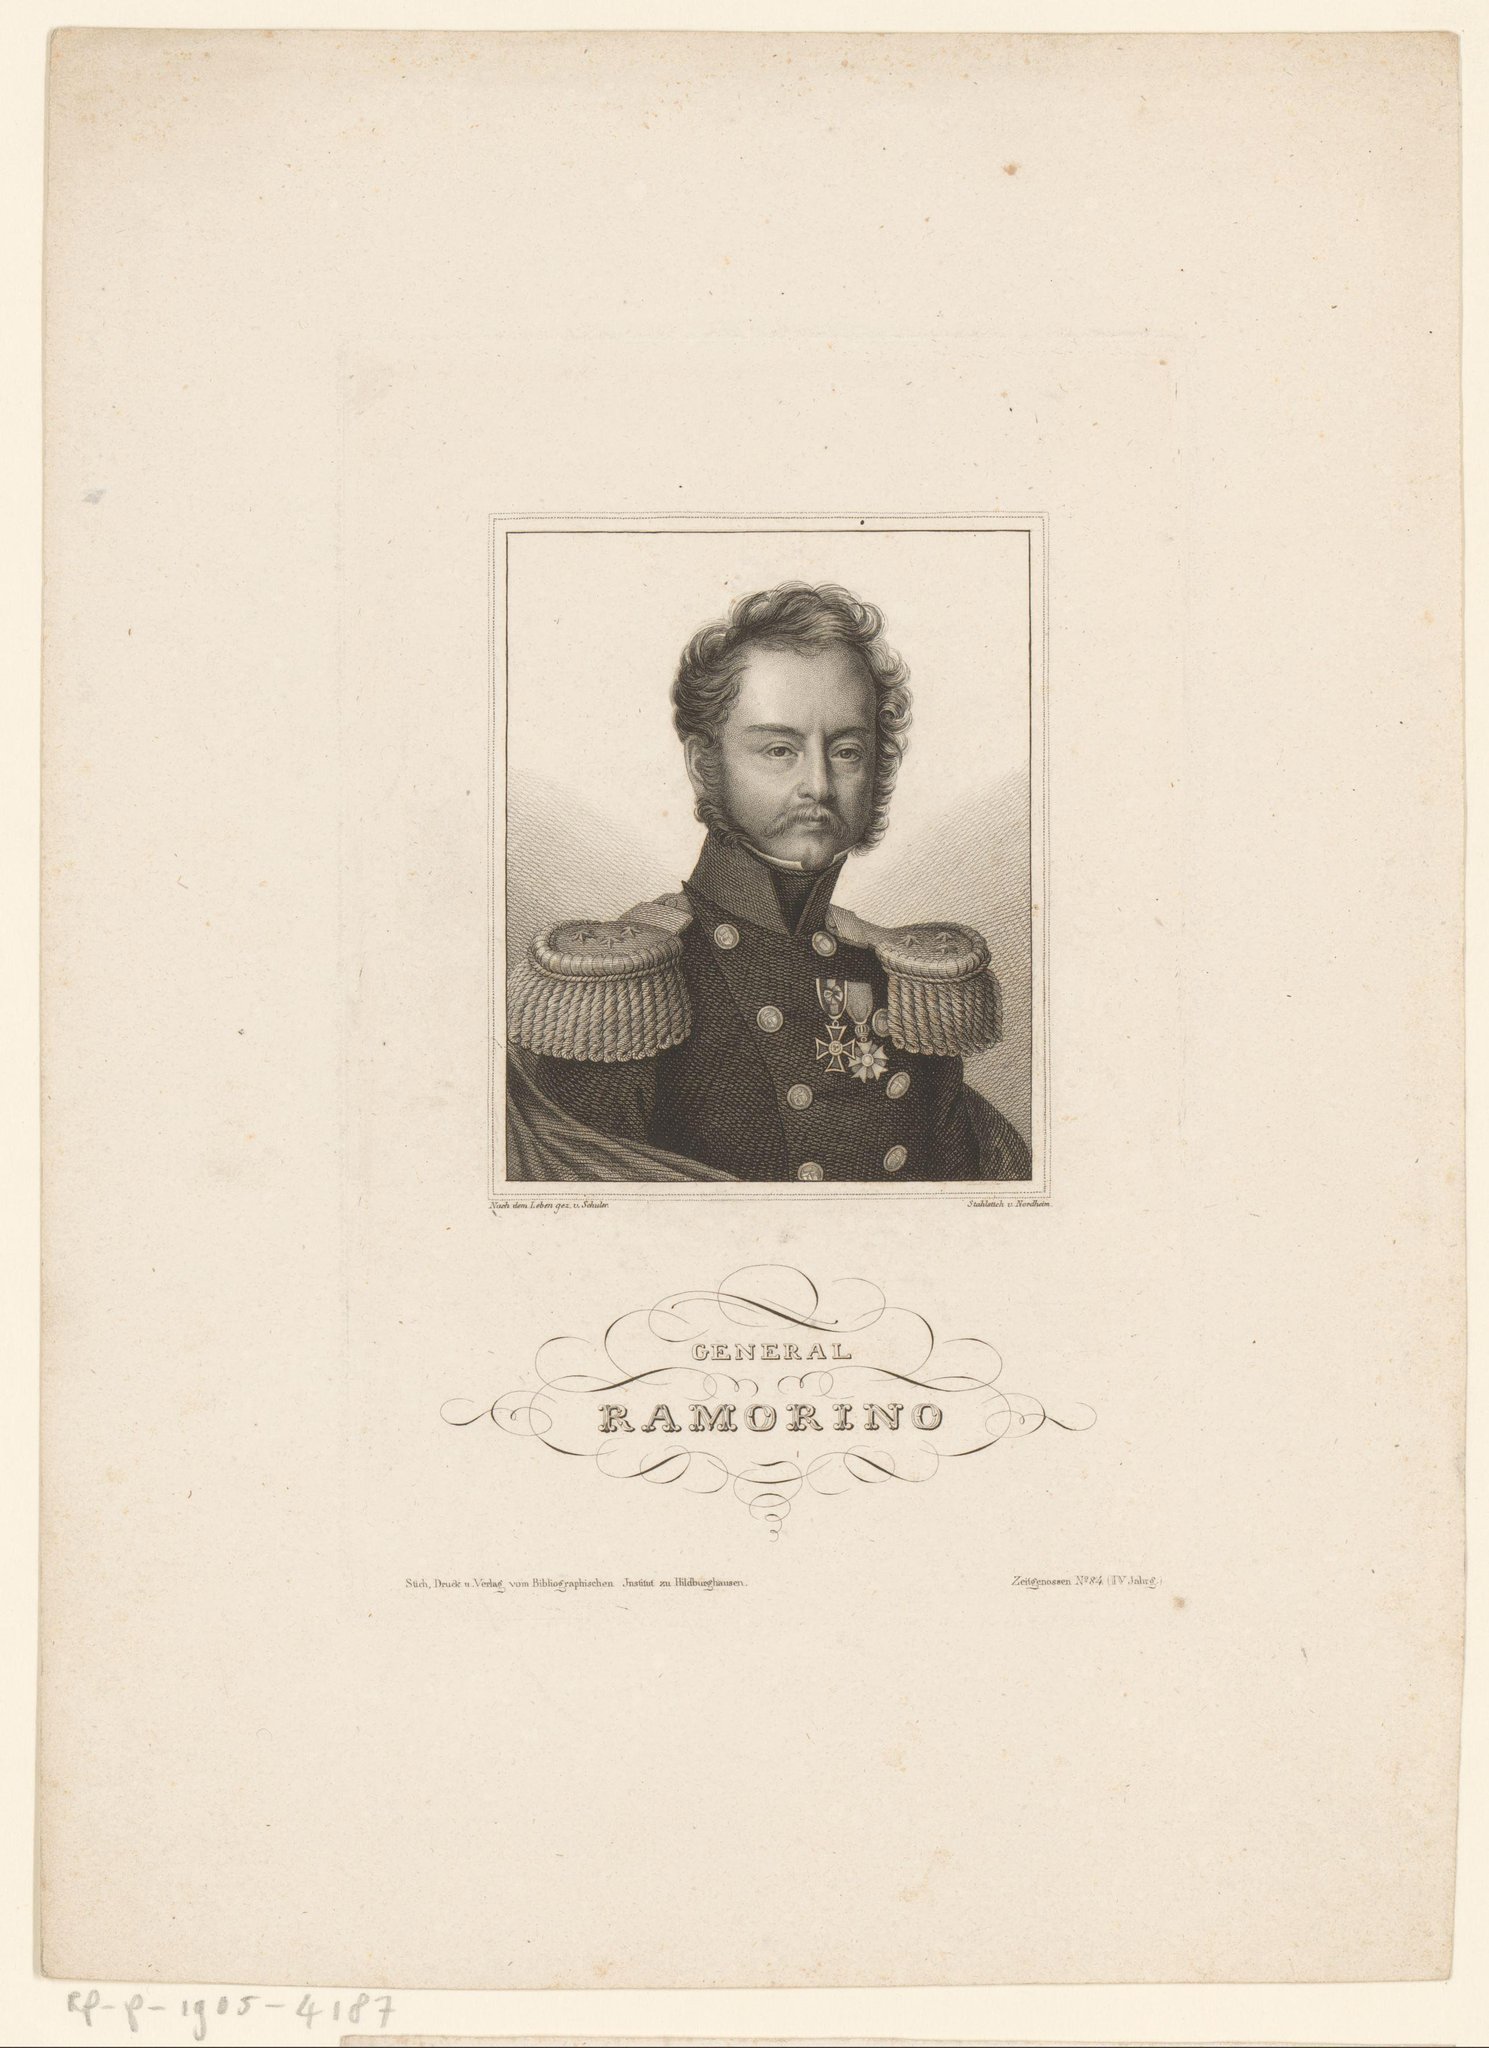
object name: print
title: Portret van Girolamo Ramorino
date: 1829-1840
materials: paper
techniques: engraving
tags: historical persons, medals and other marks of military honour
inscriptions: collector's mark: Lugt 2228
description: Afkomstig uit de portretserie 'Zeitgenossen', uitgegeven tussen 1829 en circa 1840.